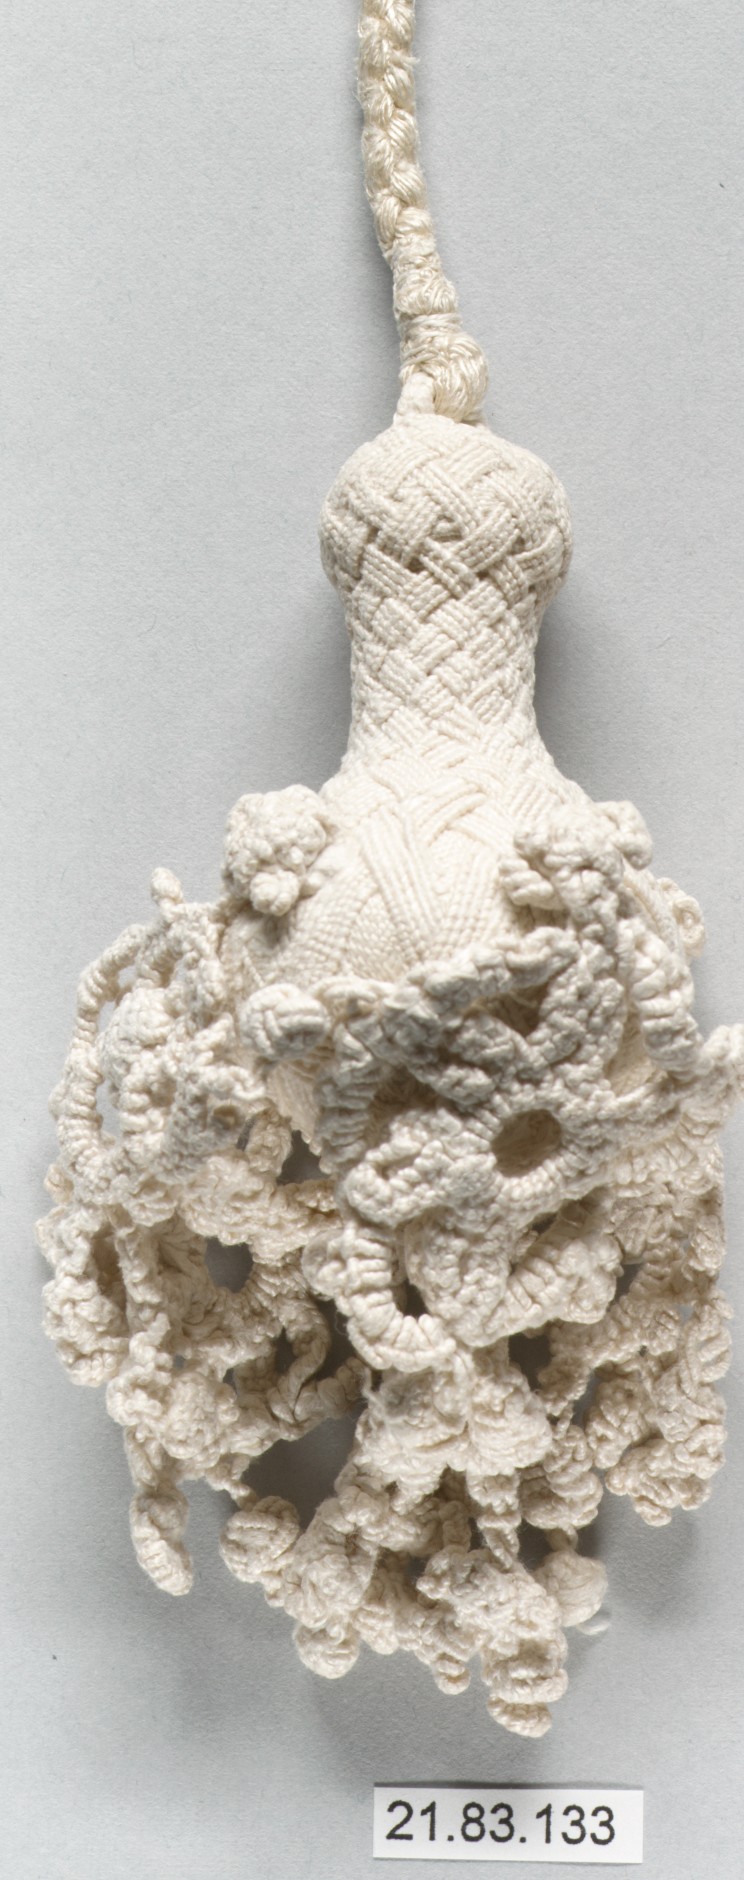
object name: tassel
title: Pair of tassels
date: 1601-1700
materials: linen